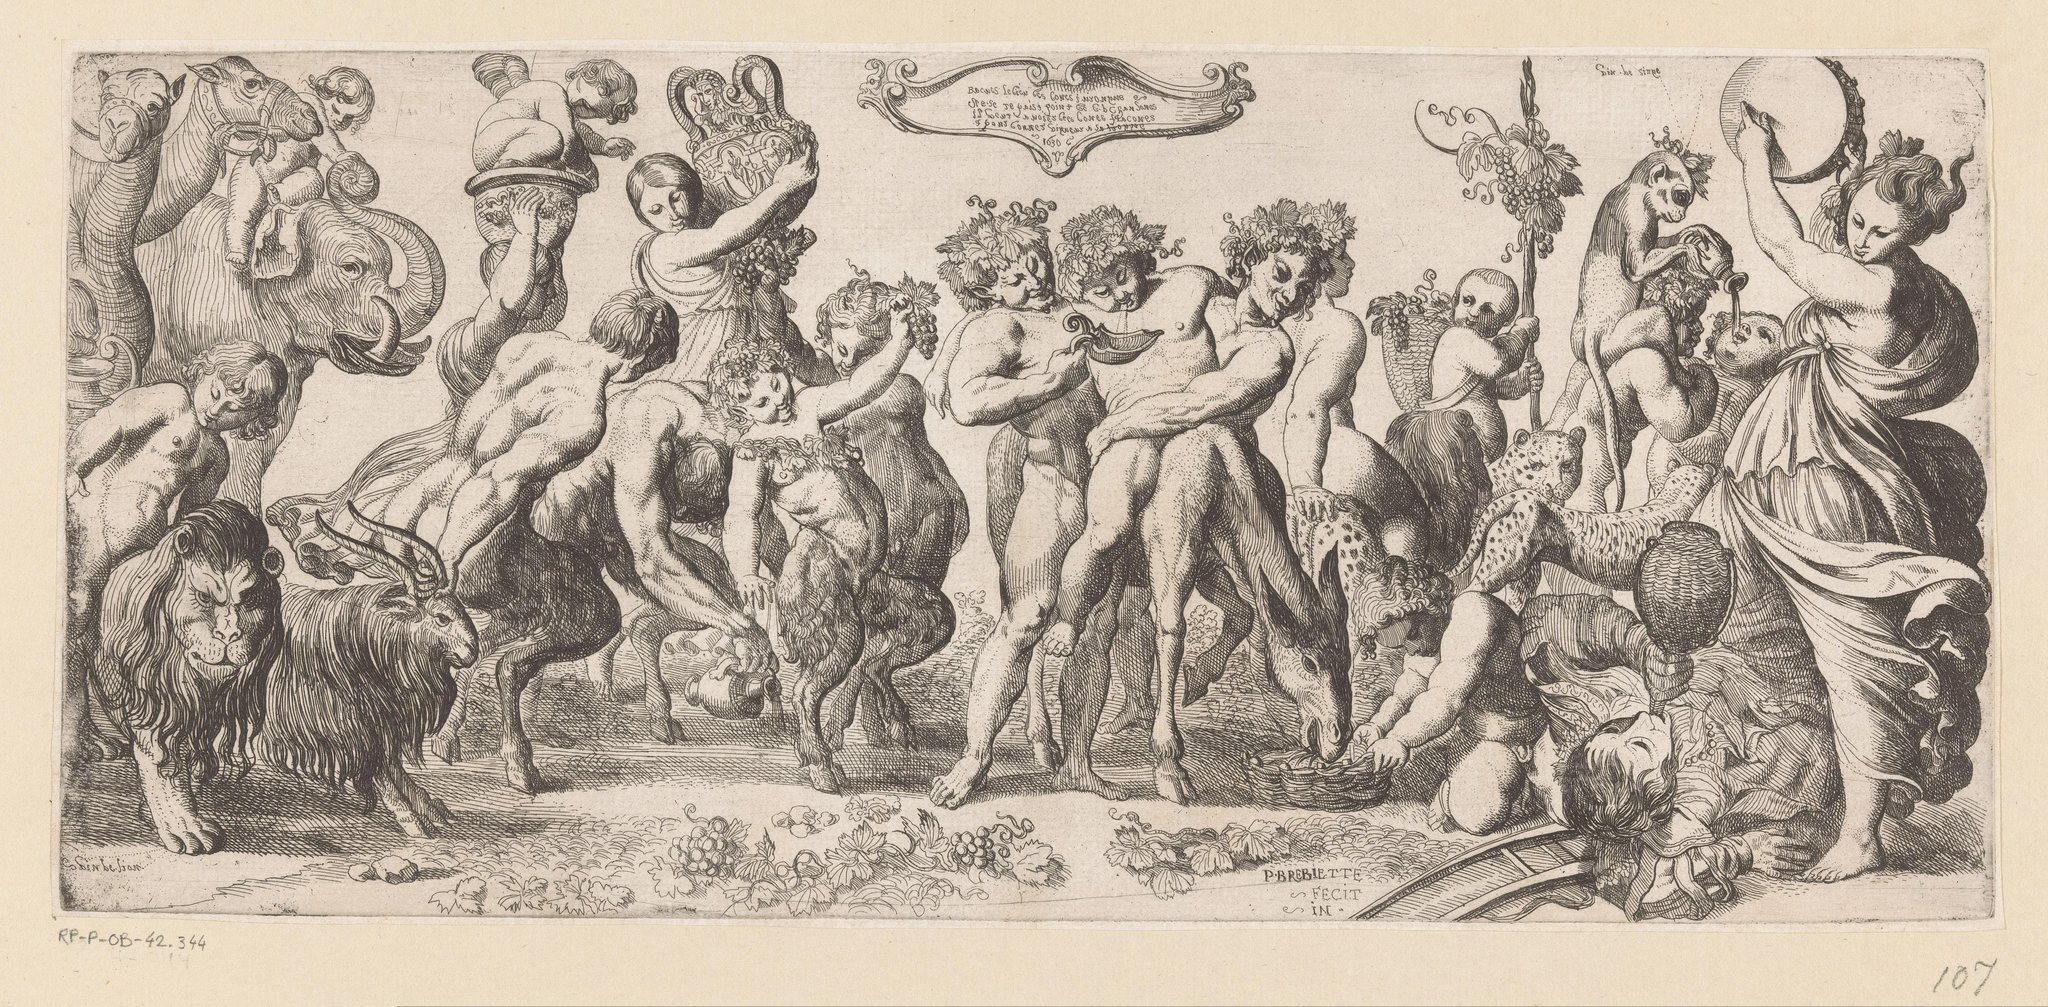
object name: print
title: Bacchus en zijn gevolg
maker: pierre brebiette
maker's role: draughtsman, print maker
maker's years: 1598-1650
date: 1630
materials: paper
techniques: etching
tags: hoofed animals: camel, beasts of prey, predatory animals: leopard, monkeys, apes, bacchanal: bacchus with his wine-flushed train (thiasos), goat, beasts of prey, predatory animals: lion, trunked animals: elephant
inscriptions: collector's mark: Lugt 240